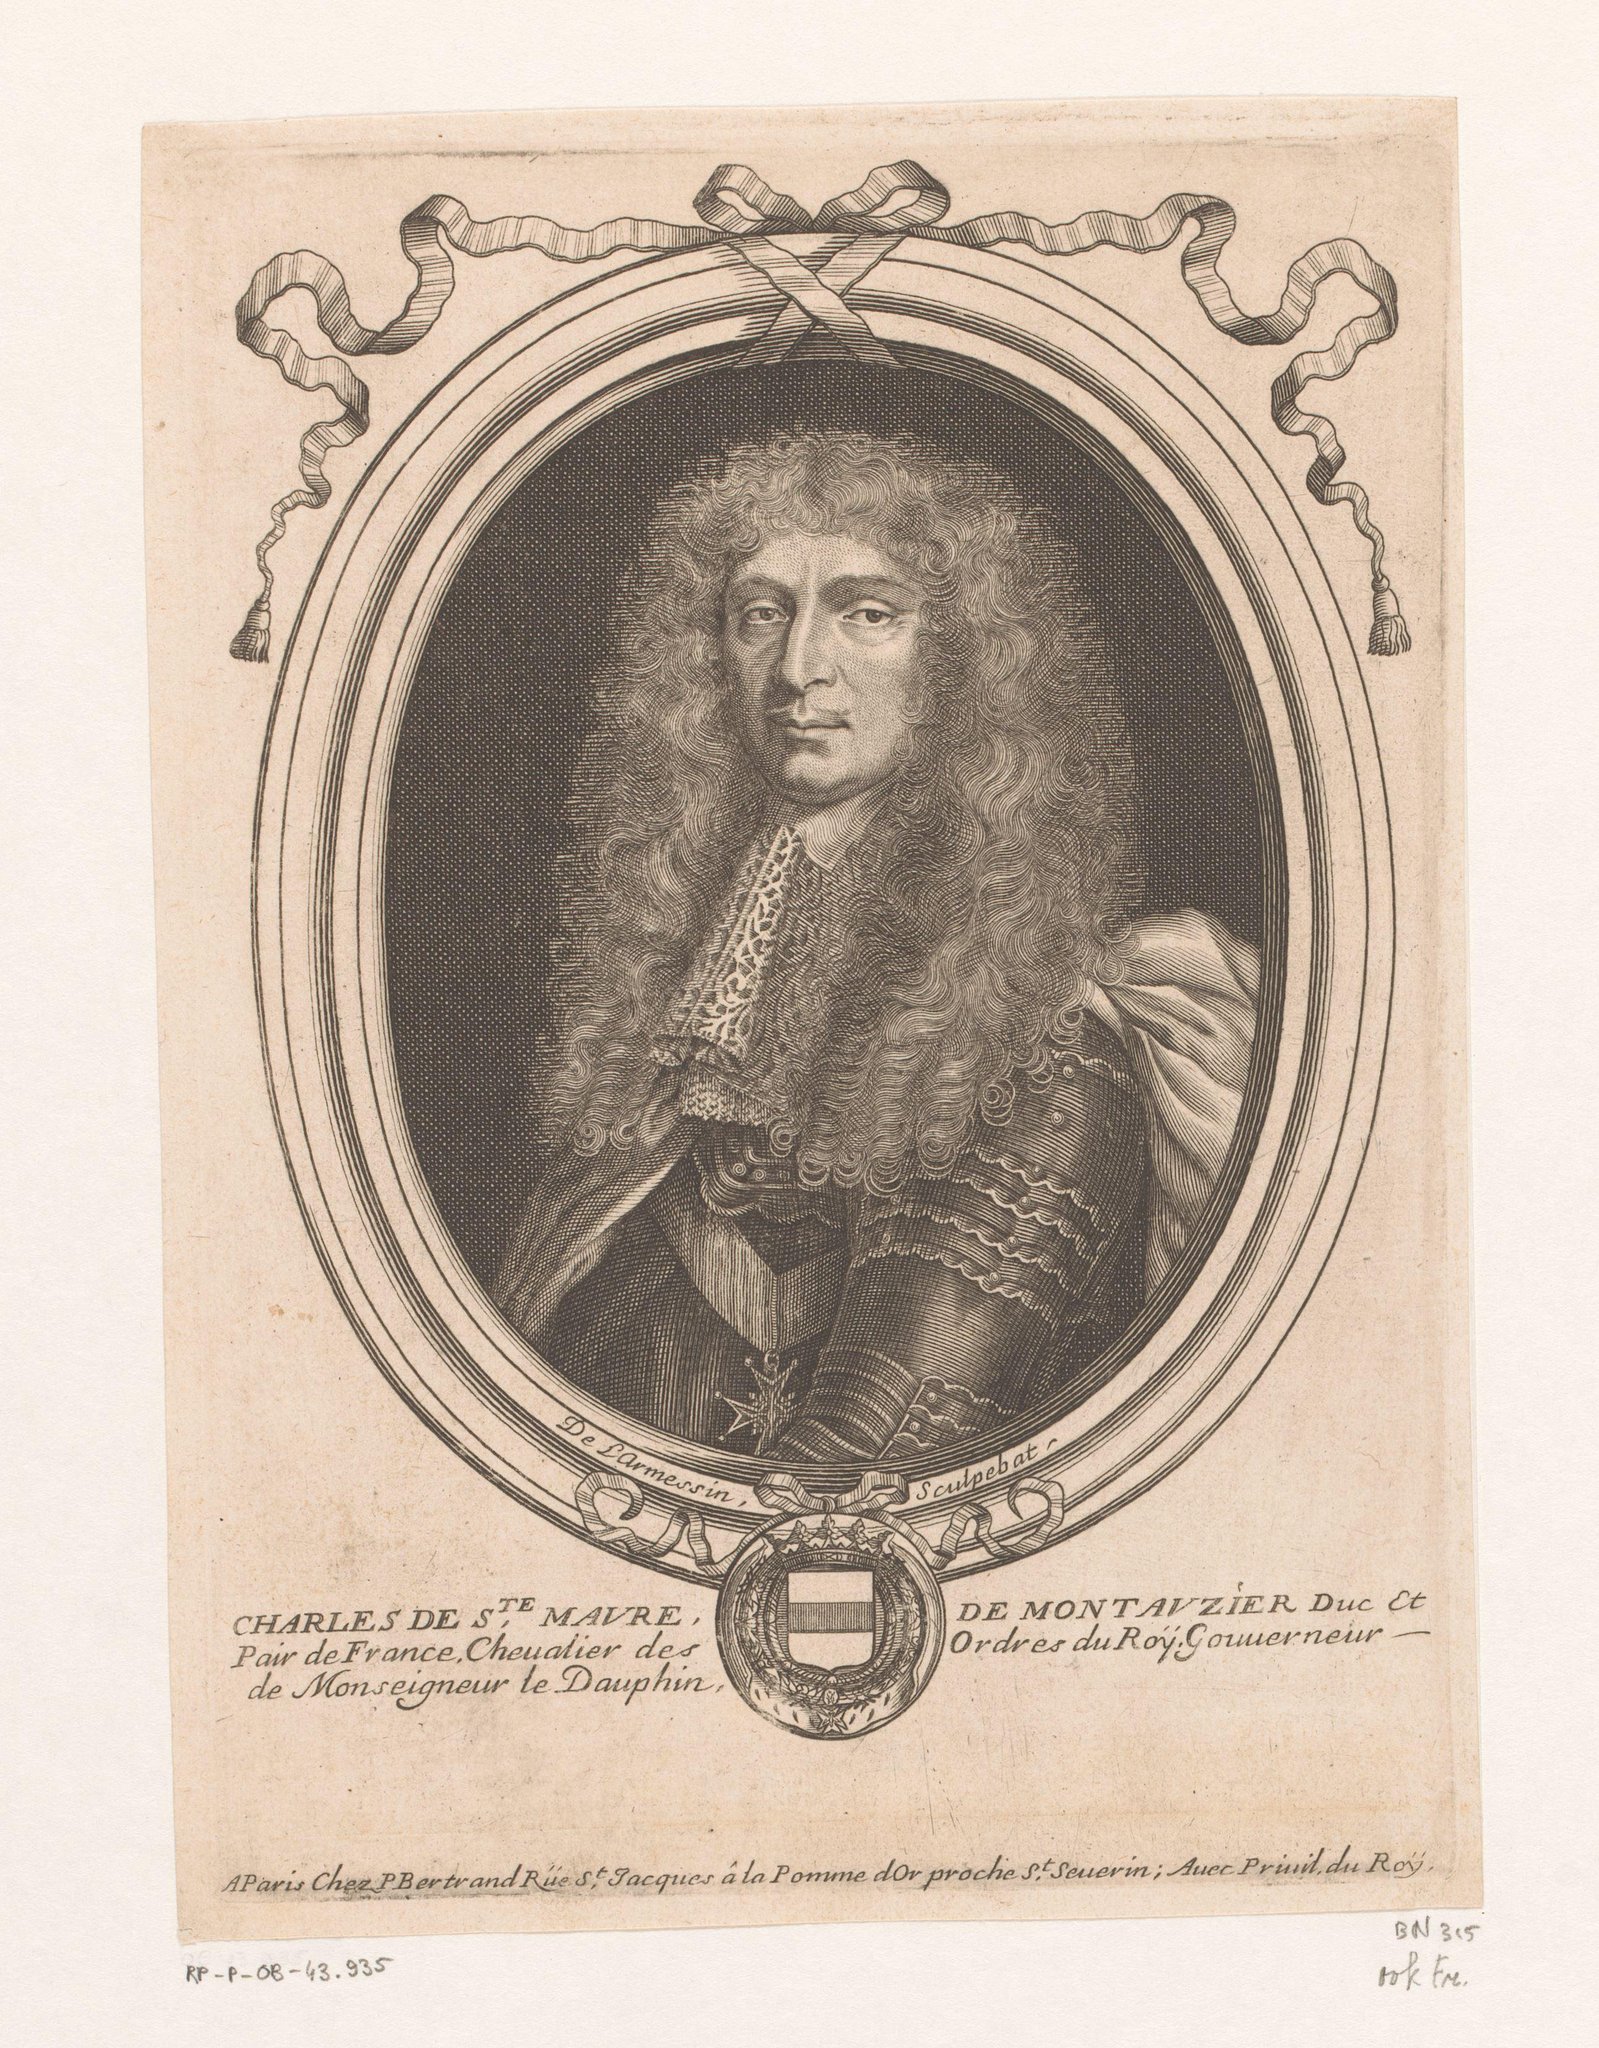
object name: print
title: Portret van Charles de Sainte-Maure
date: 1642-1678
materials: paper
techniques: engraving, etching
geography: france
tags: historical persons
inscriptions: collector's mark: Lugt 2228, number: ‘896’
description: Maakt deel uit van een grootschalige serie met portretten van prominente figuren. Binnen de serie bevindt zich een sectie getiteld 'Les Augustes Représentations De tous les Roys De France depuis Pharamond Iusqu'à Louys XIIII'. De serie werd respectievelijk uitgegeven door Pierre Bertrand, door zijn weduwe en door De Larmessin zelf.